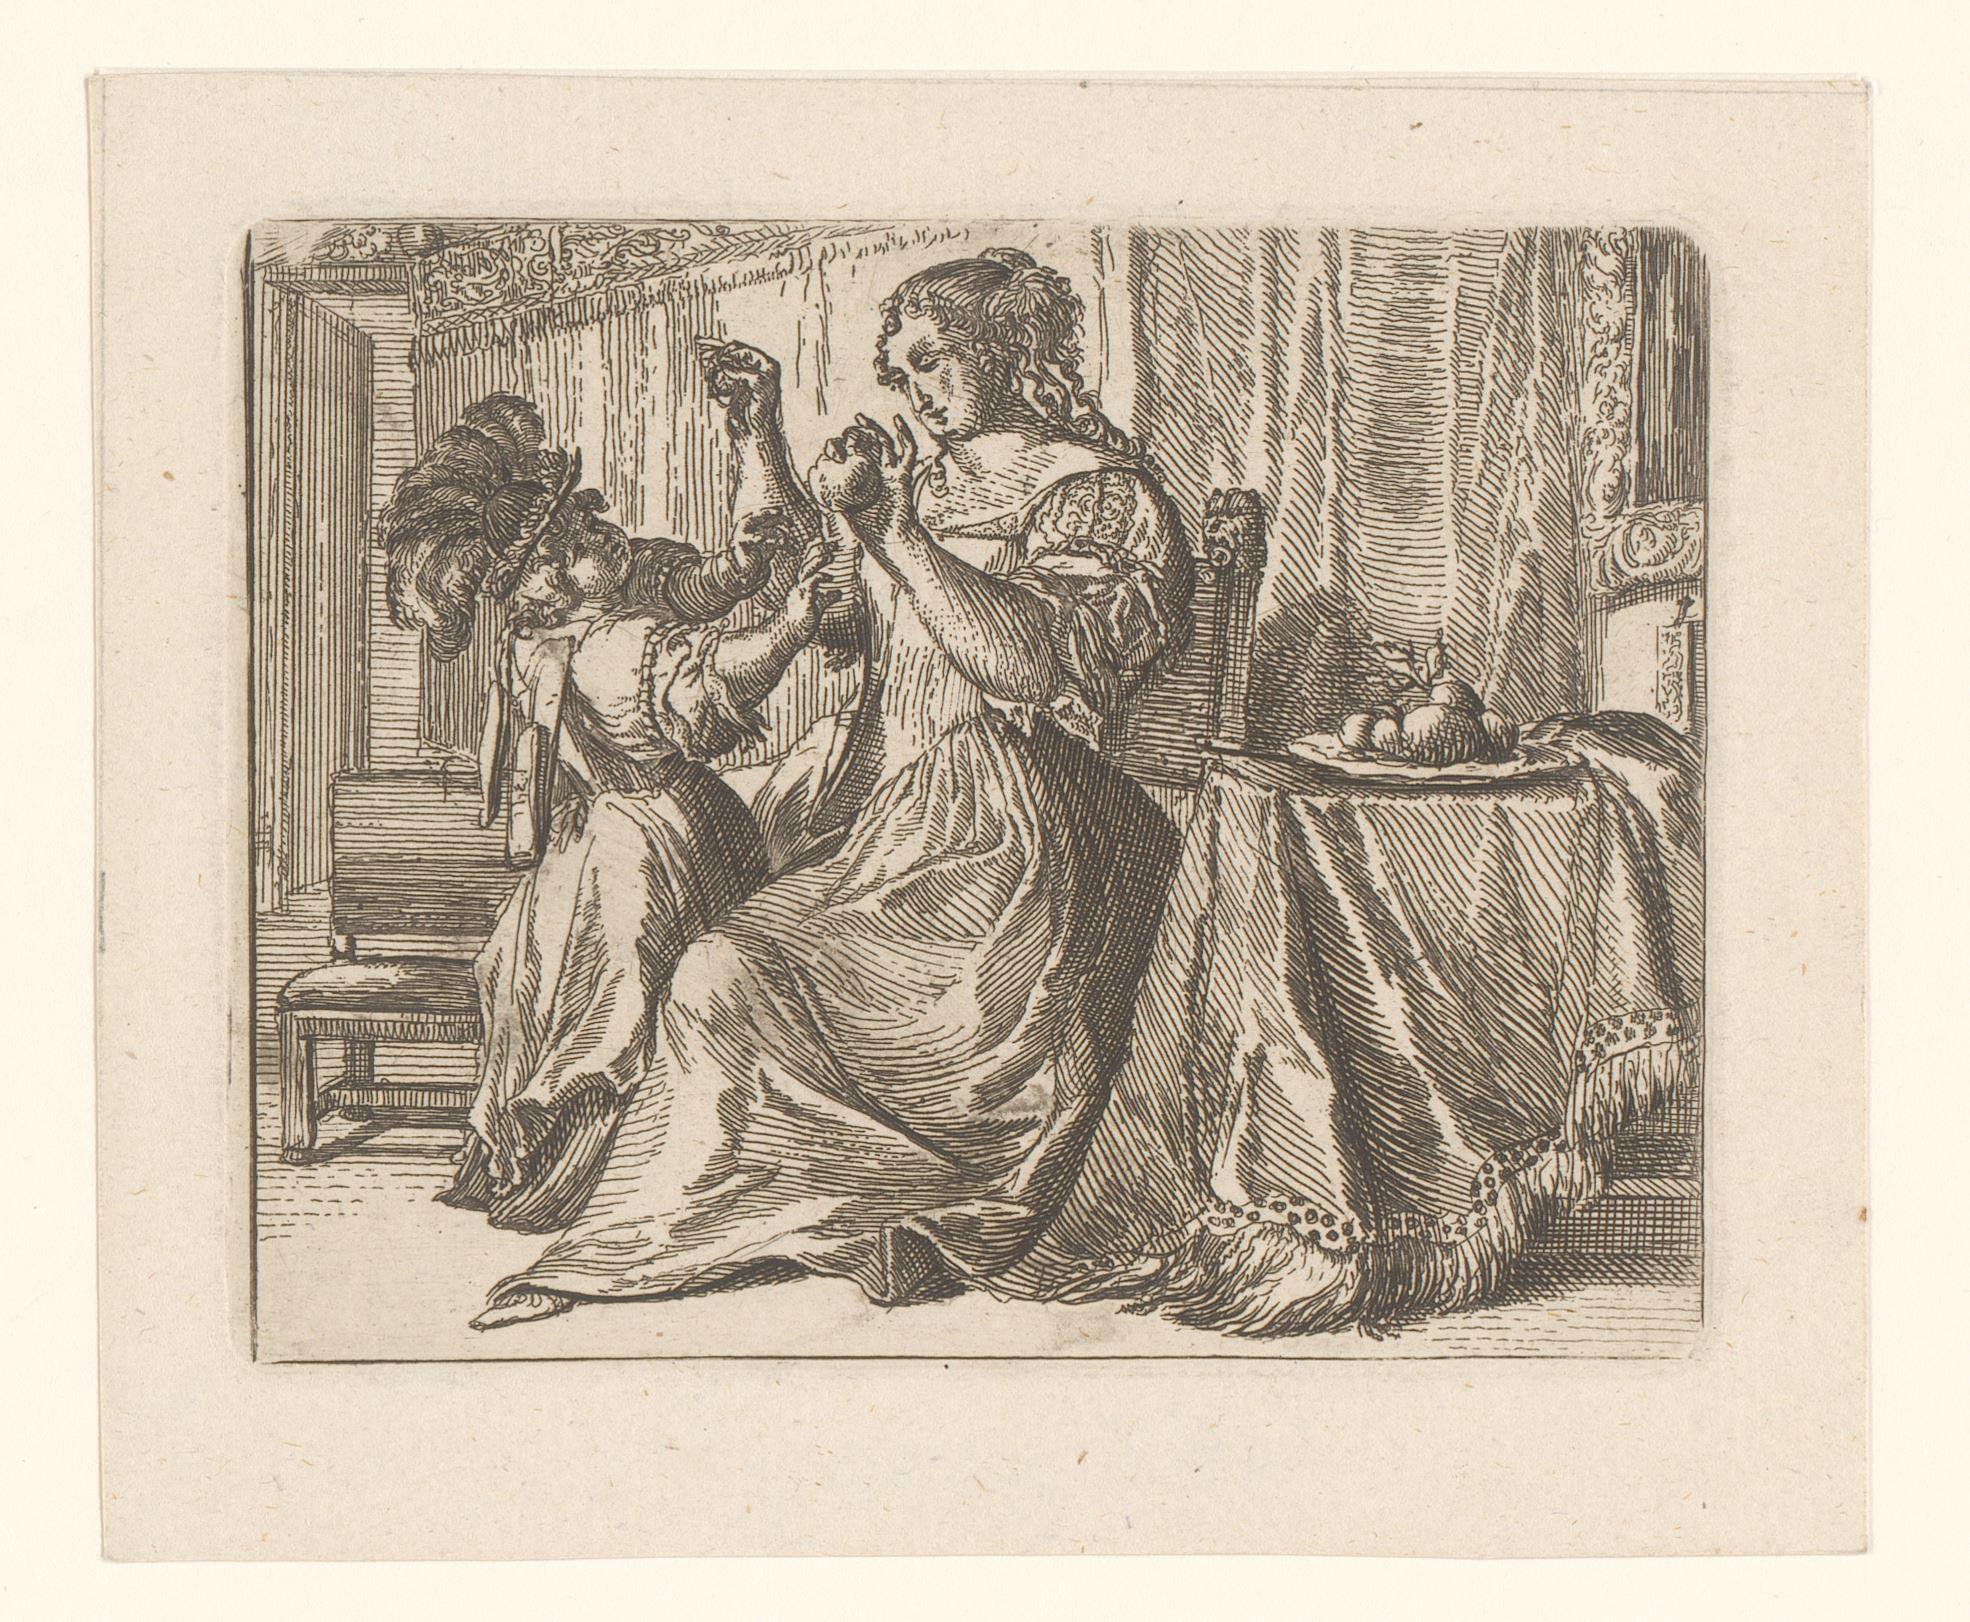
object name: print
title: Dame laat een kind kiezen tussen een appel en een peer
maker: romeyn de hooghe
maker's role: draughtsman, goldsmith, painter, print maker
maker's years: 1645-1708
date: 1668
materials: paper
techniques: etching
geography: northern netherlands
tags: mother with daughter(s) (mother-love), fruits: apple, fruits: pear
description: Prent met tekst in boekdruk op verso gebruikt in: Hoogstraten, Frans van. Het Voorhof der Ziele (...). Rotterdam: Frans van Hoogstraten, 1668. Ook gebruikt in de herdruk van 1698.